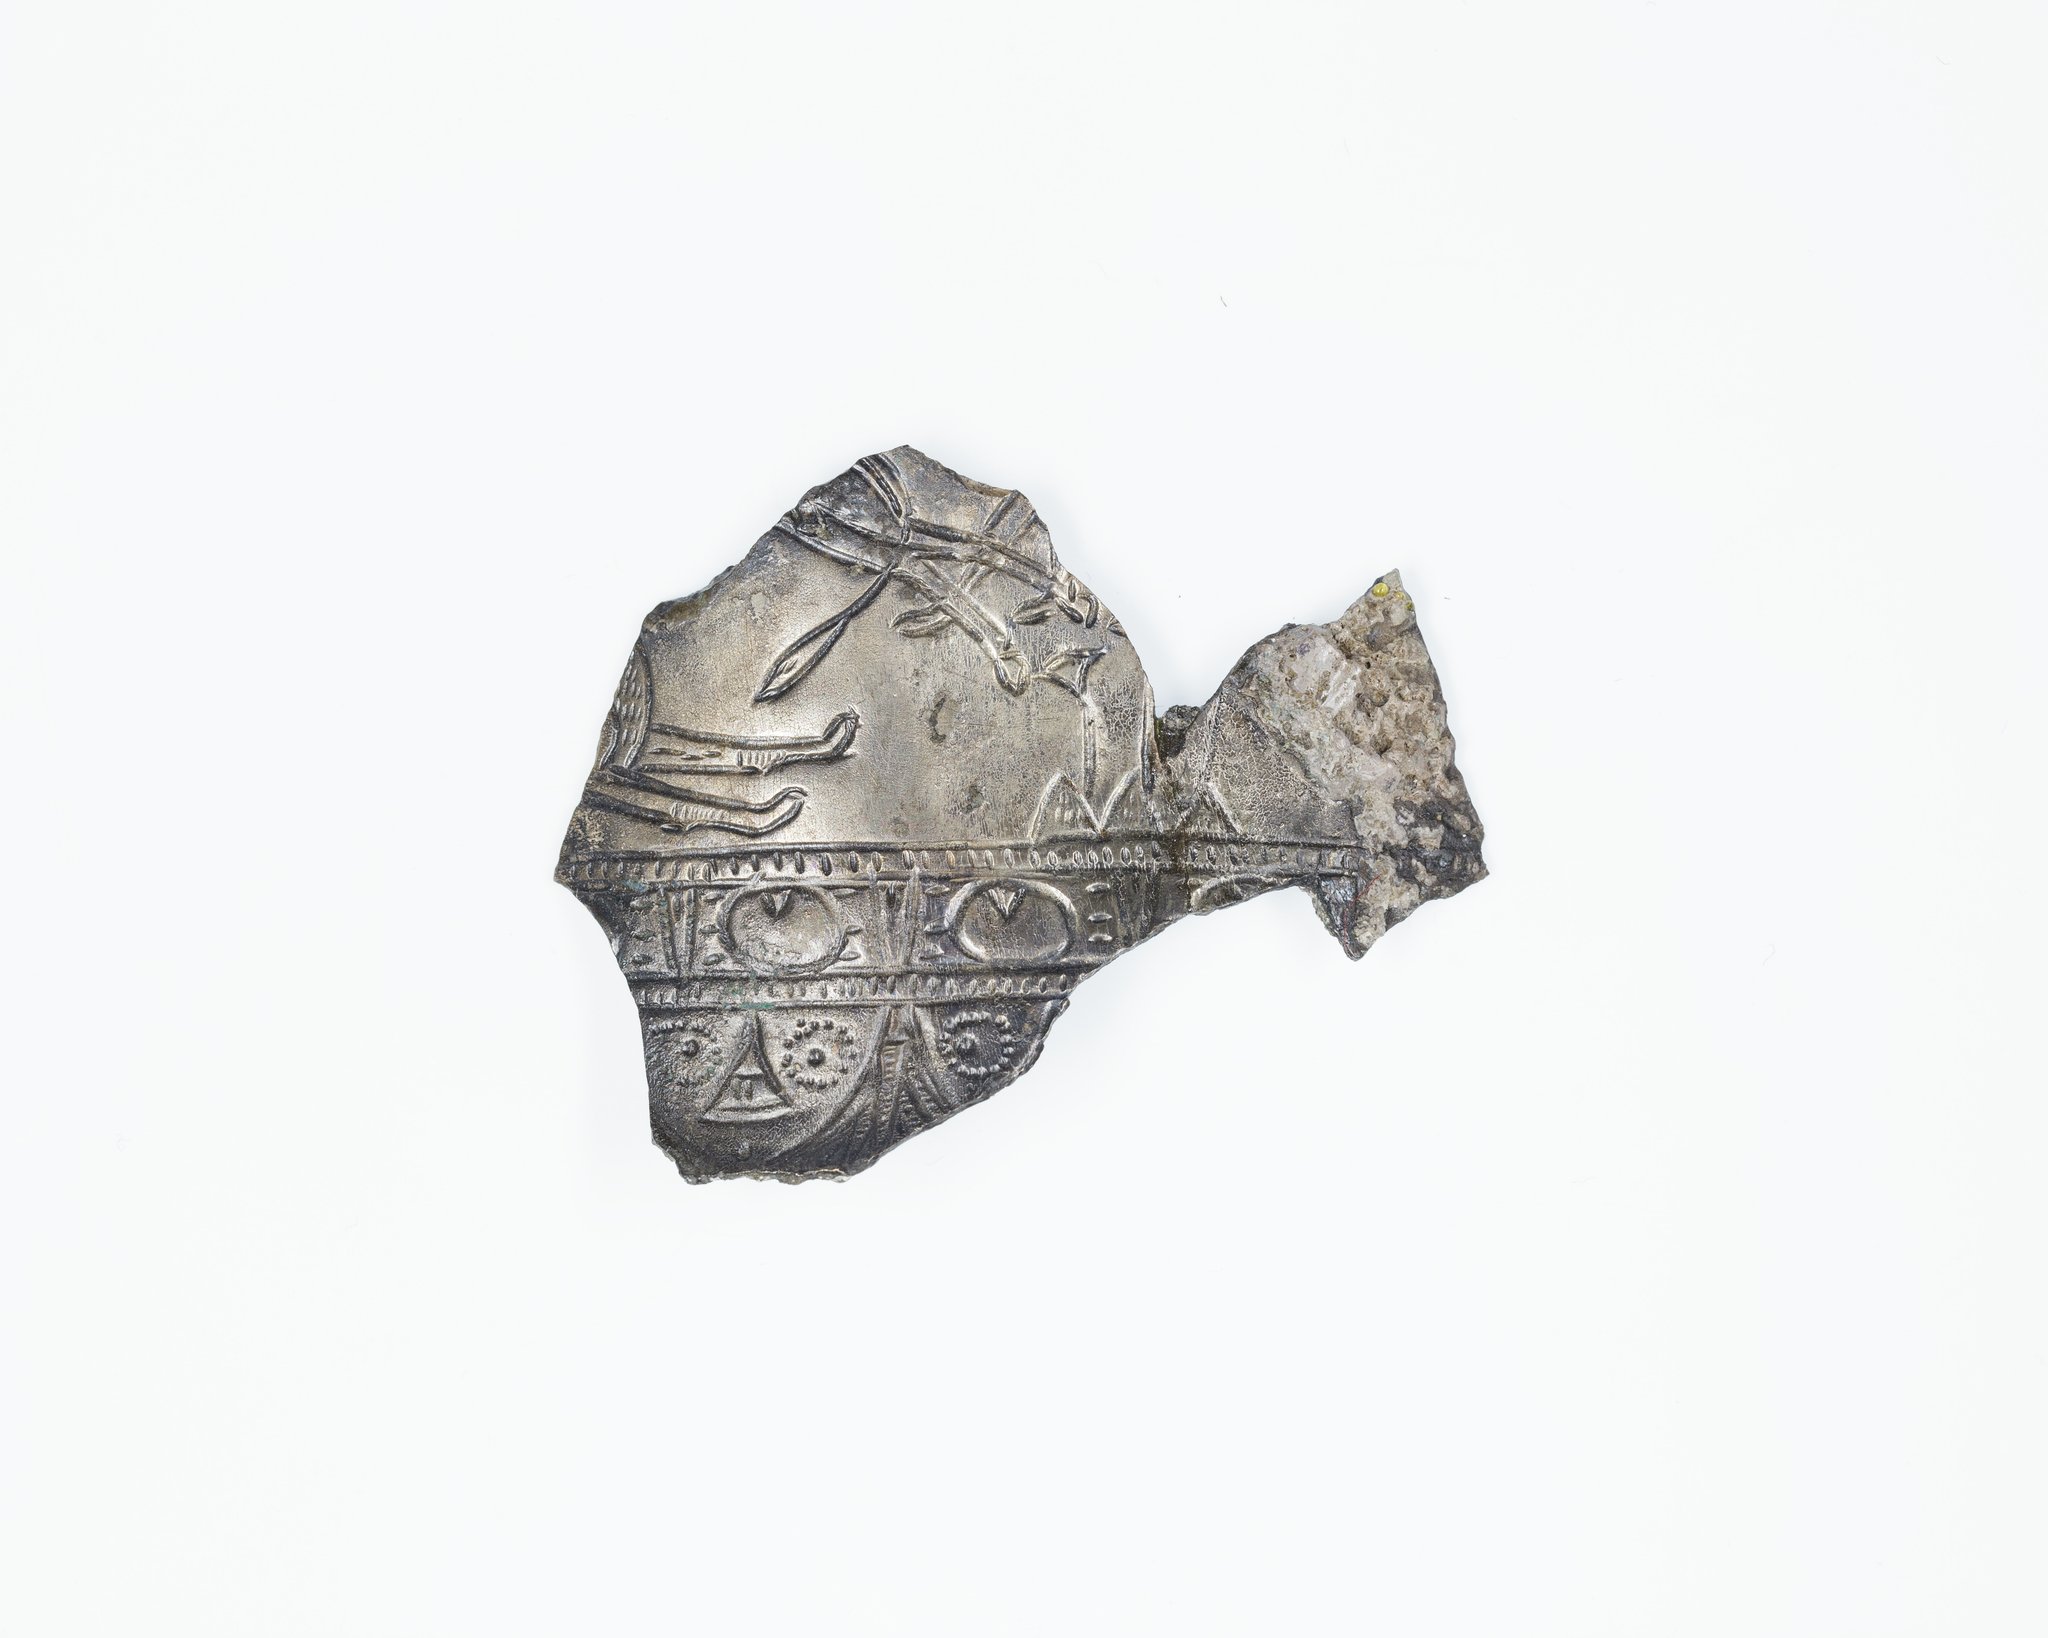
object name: strainer or vase fragment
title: Fragment of a pitcher naming Atumemtaneb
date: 1295-1070 BCE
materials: silver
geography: egypt